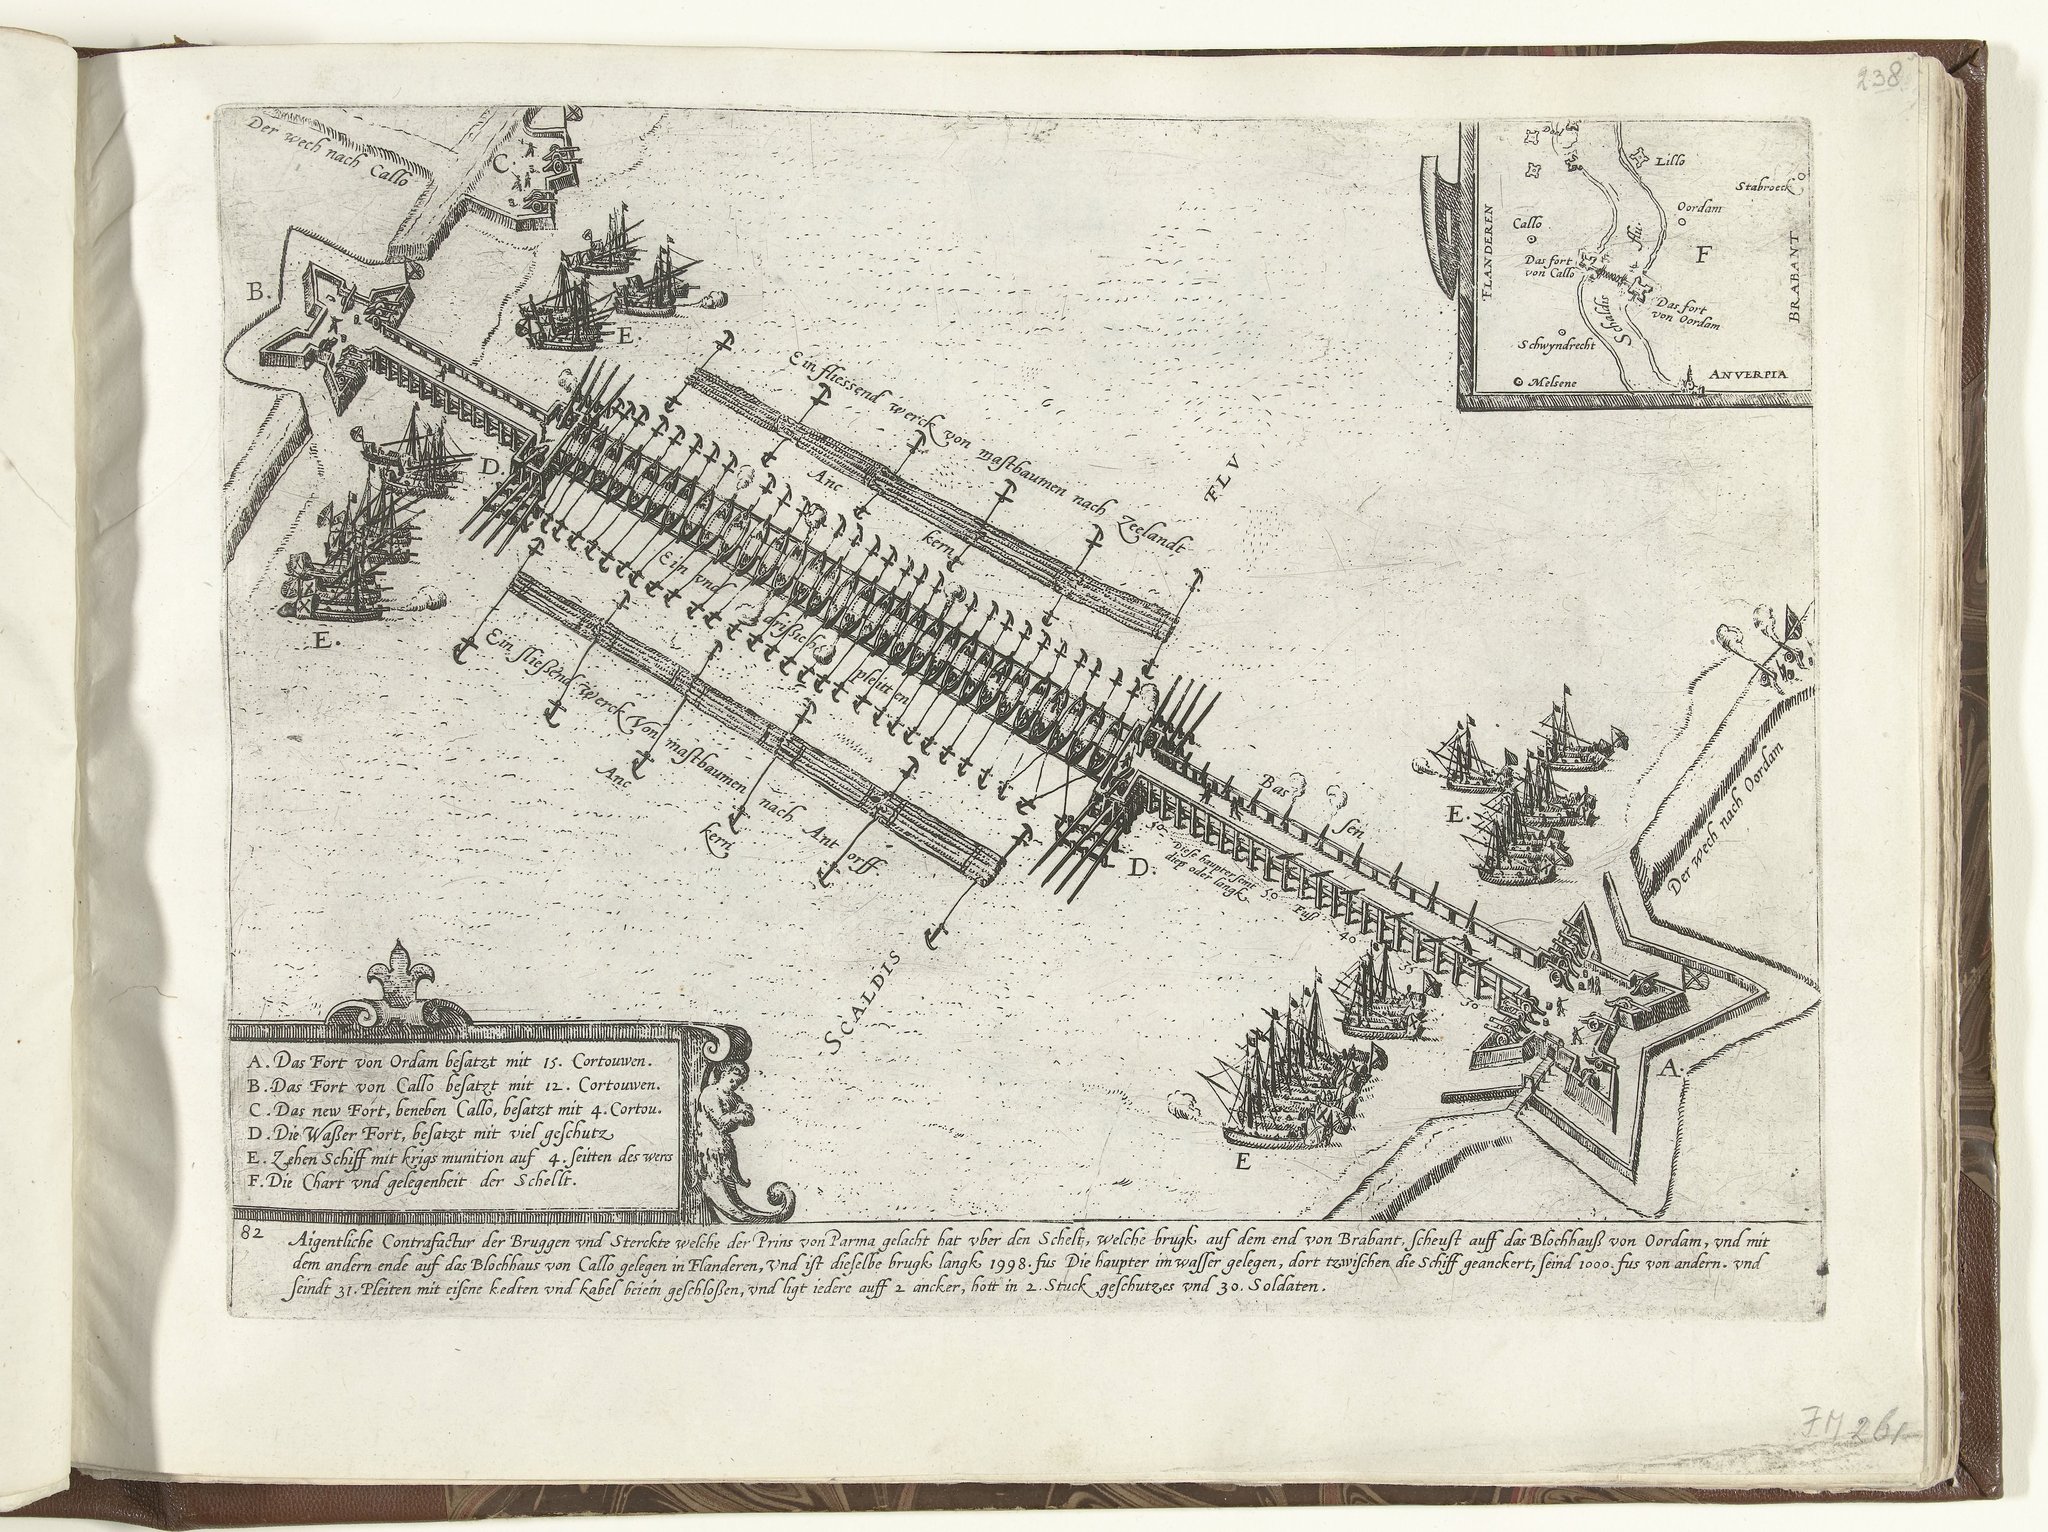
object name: album leaf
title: Serie 9: Nederlandse en Duitse Gebeurtenissen, 1583-1587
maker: frans hogenberg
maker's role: print maker, publisher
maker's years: 1538-1590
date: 1585-1587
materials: paper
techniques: etching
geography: cologne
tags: rome, alessandro farnese (landvoogd van de nederlanden en hertog van parma en piacenza), pontoon bridge, antwerp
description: Schipbrug gebouwd door het leger van de hertog van Parma waarmee de Schelde naar Antwerpen afgesloten werd. Voltooid op 24 februari 1584. Linksonder de legenda in een cartouche, rechtsboven een inzet met een kaartje van de regio. Met onderschrift van 3 regels in het Duits. Genummerd: 82.